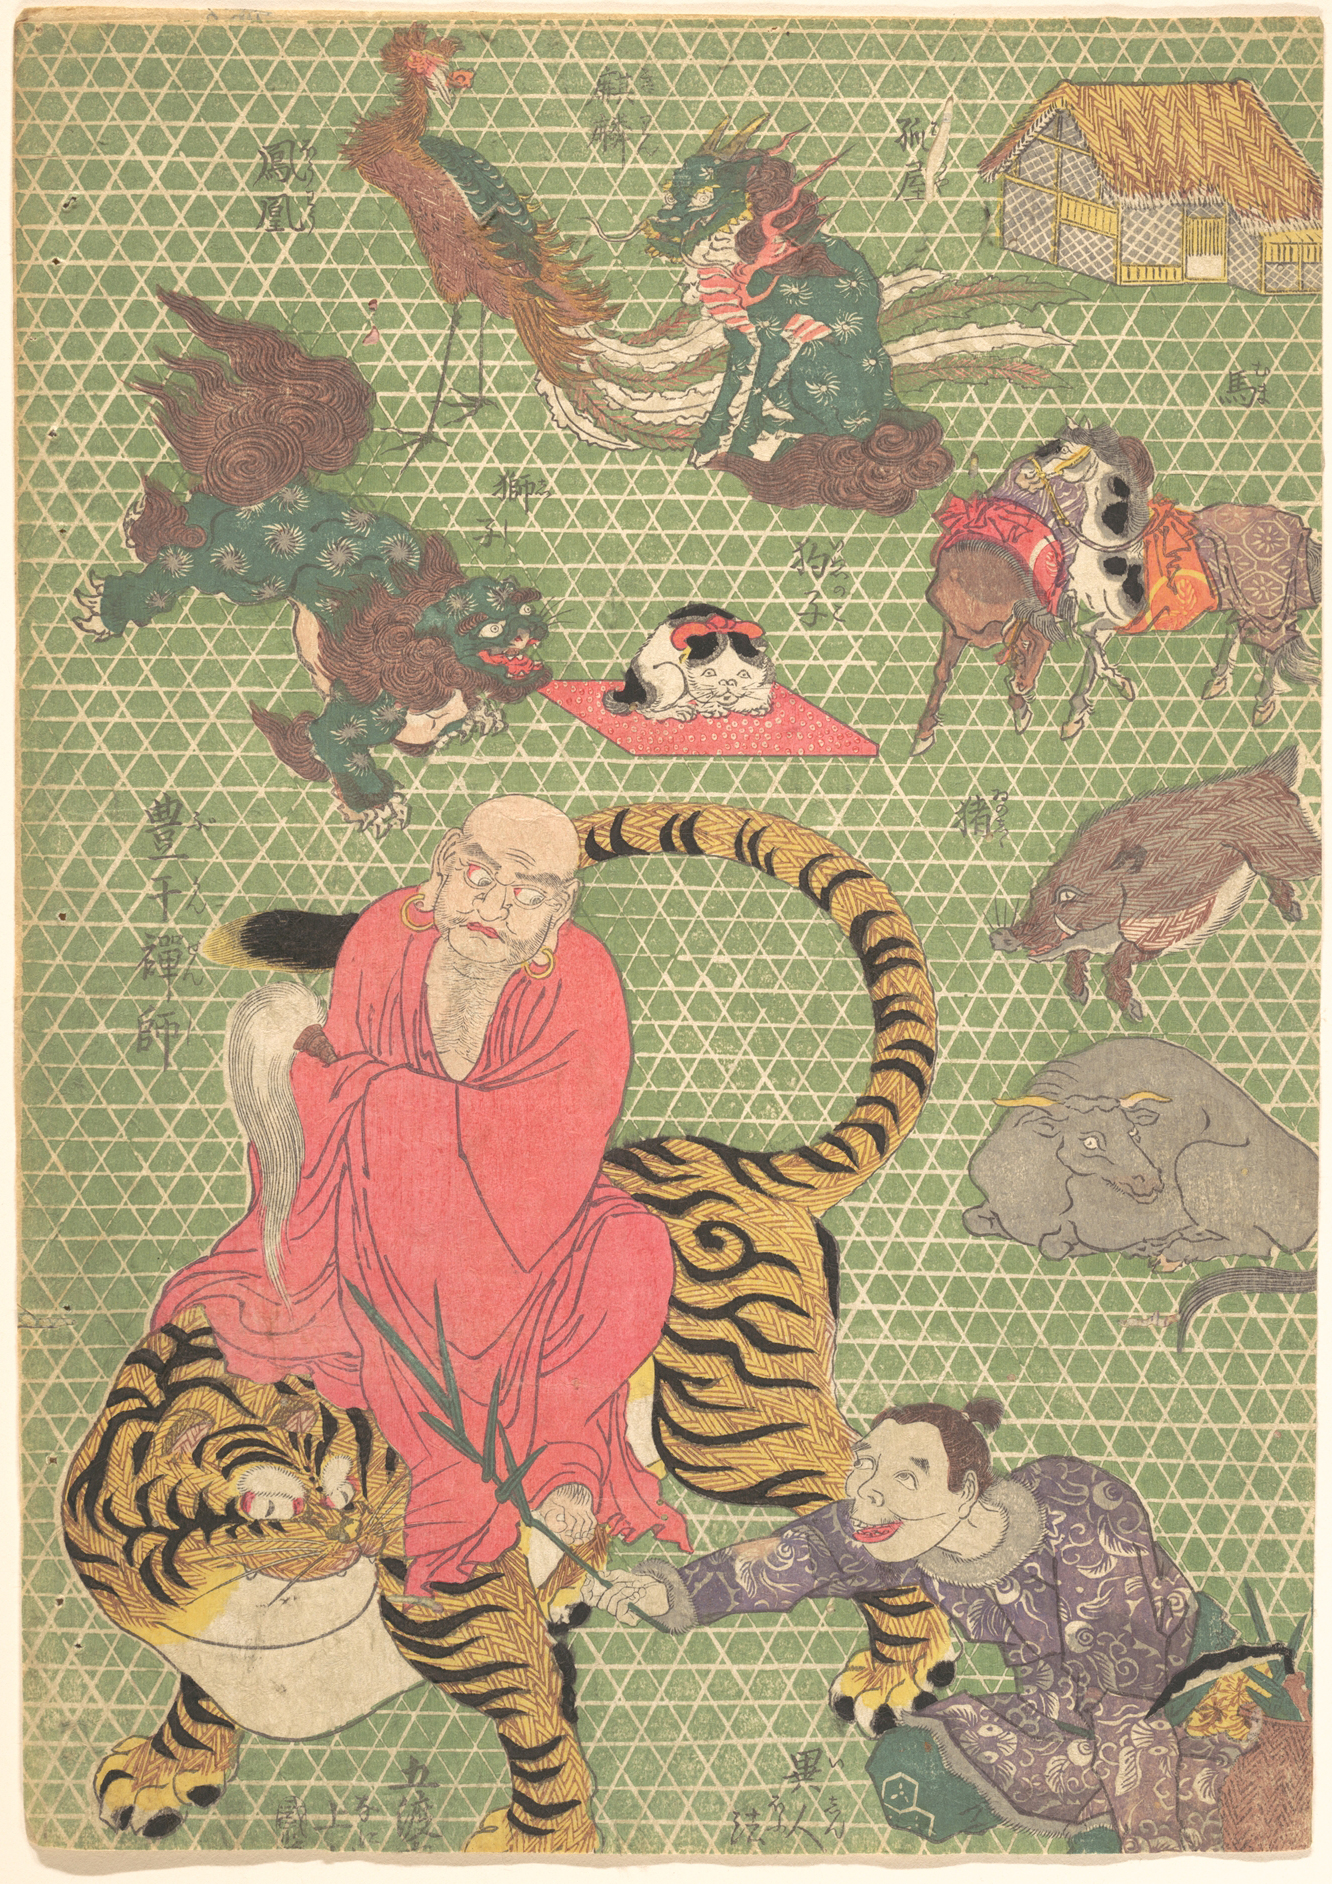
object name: print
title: Basketry Work: By the Craftsman Ichida Shōshichirō of Naniwa (Kagozaiku Naniwa saikunin Ichida Shōshichirō)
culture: japanese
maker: utagawa kunisada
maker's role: artist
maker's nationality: japanese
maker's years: 1786-1864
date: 1819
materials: ink, paper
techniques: woodblock print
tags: houses,men,mythical creatures,boars,tigers